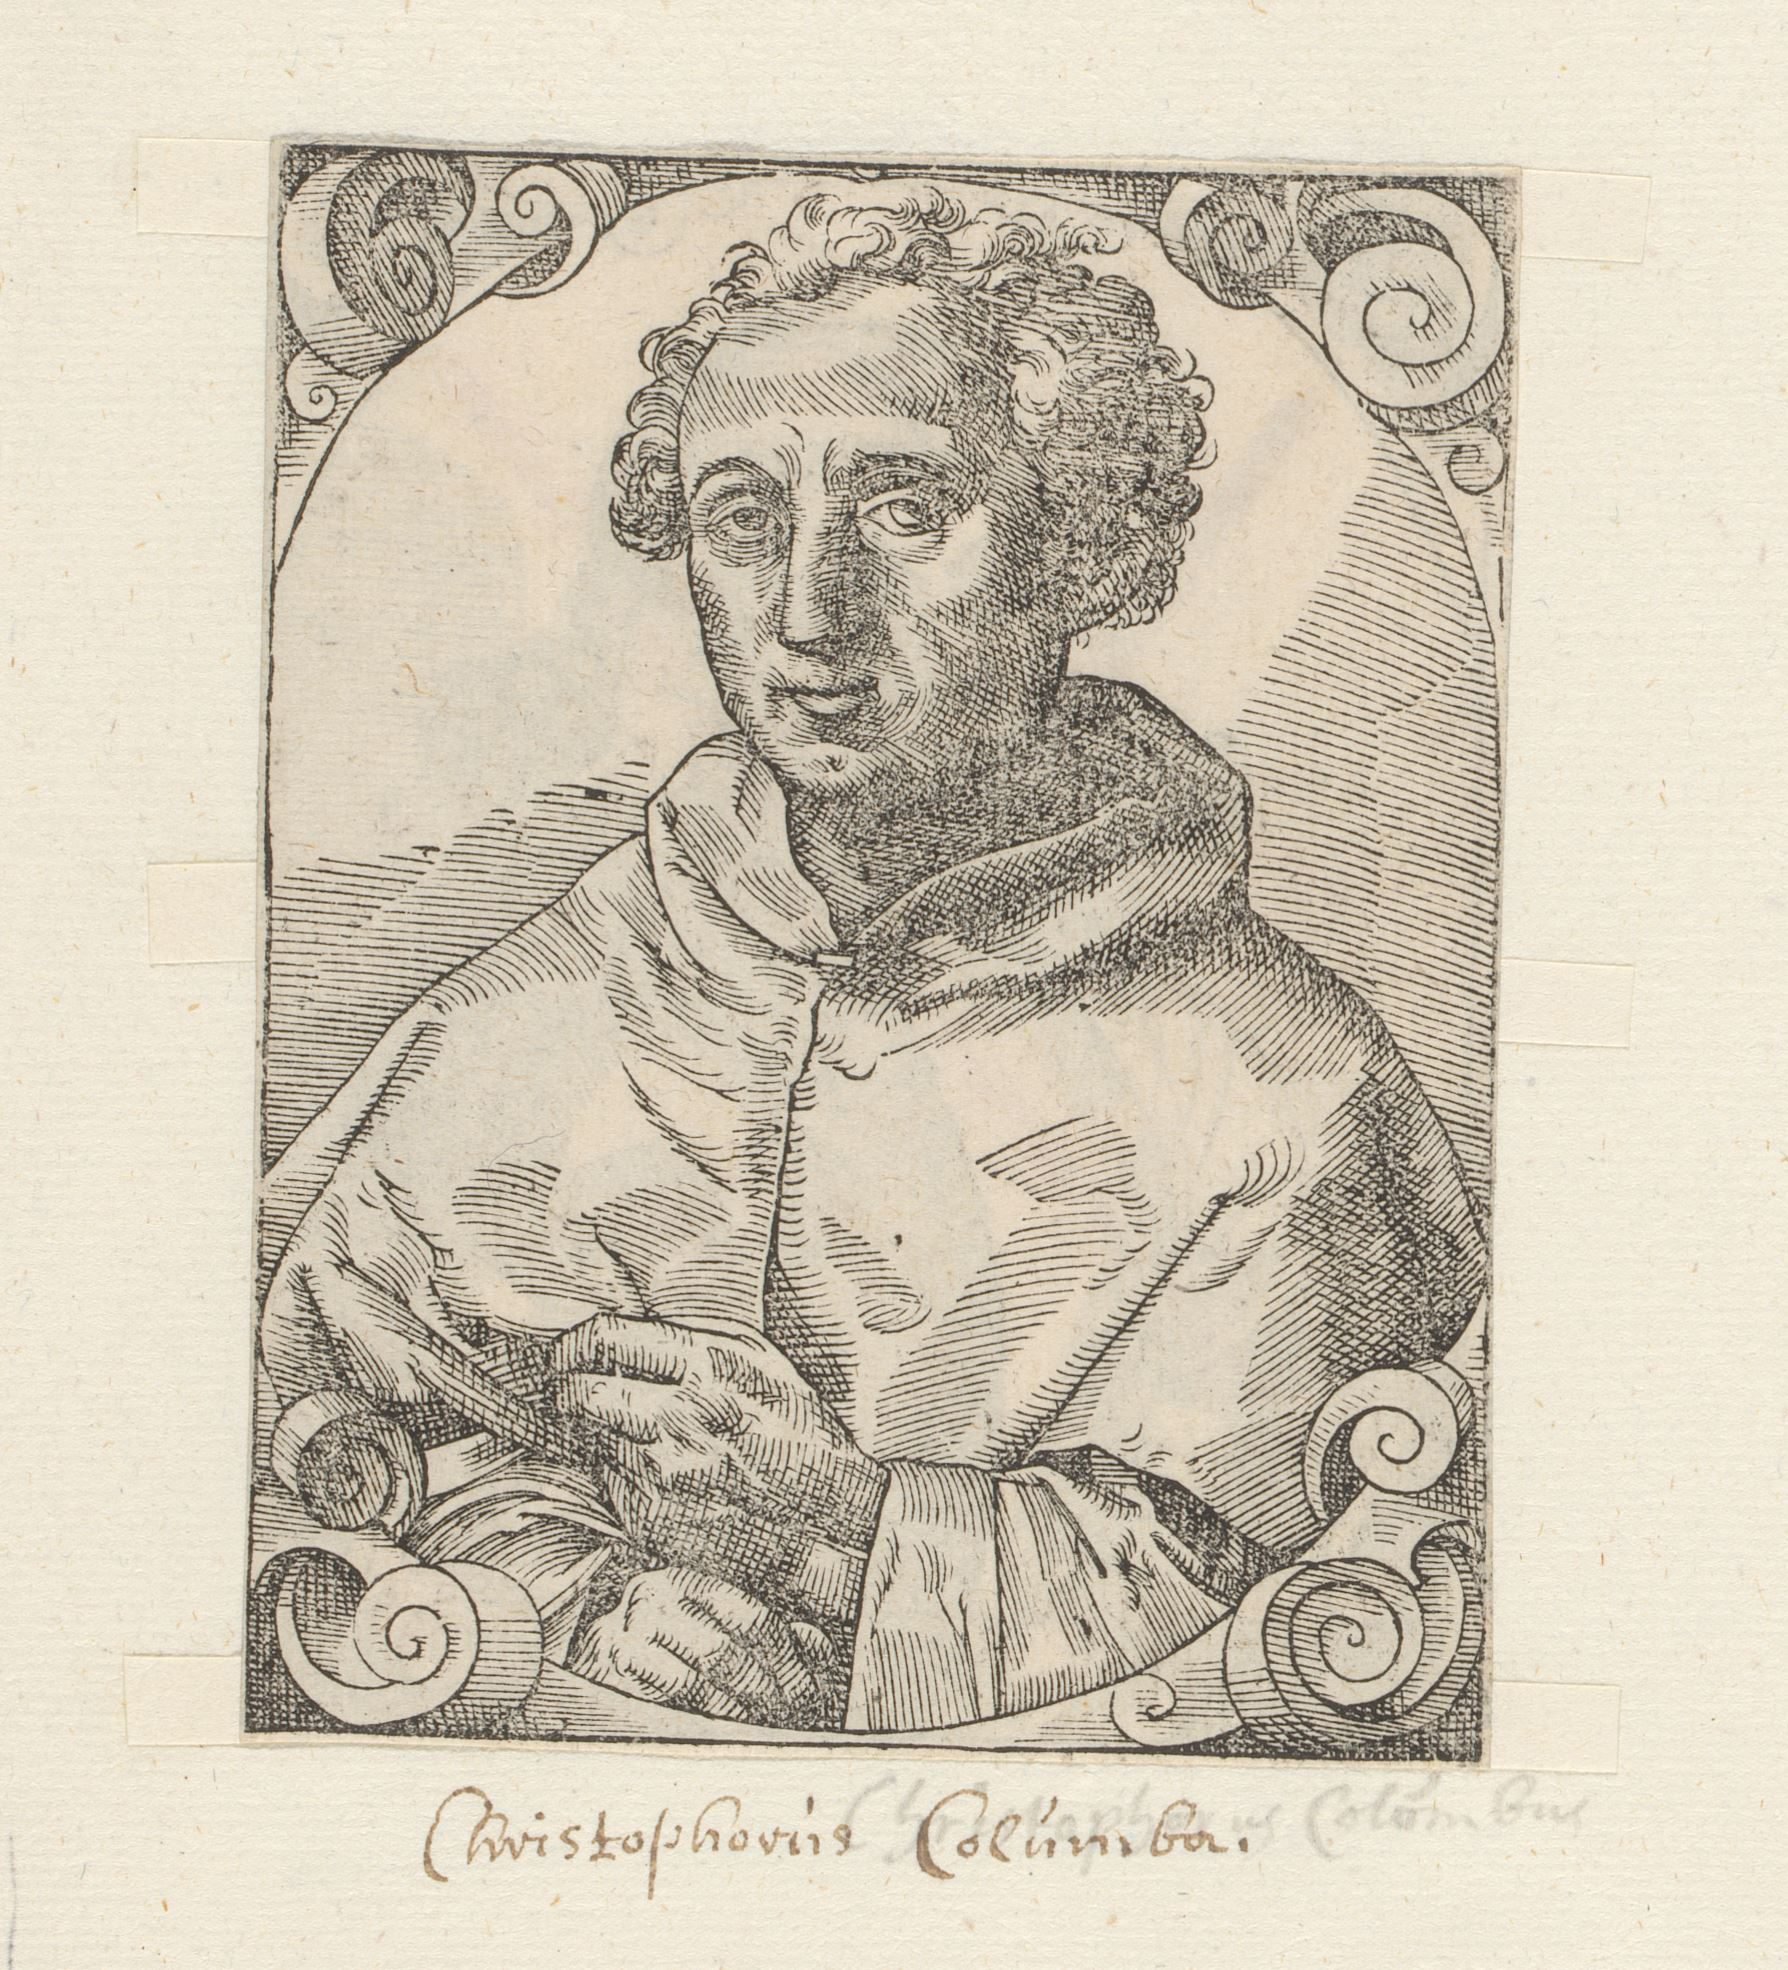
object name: album leaf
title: Portret van Christoffel Columbus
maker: Anonymous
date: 1549-1575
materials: paper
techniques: woodcut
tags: explorer (+ portrait of scholar, scientist), historical persons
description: Prent gebruikt in: Giovio, Paolo. Elogia Virorum bellica virtute illustrium (...). Bazel: Peter Perna, 1575.